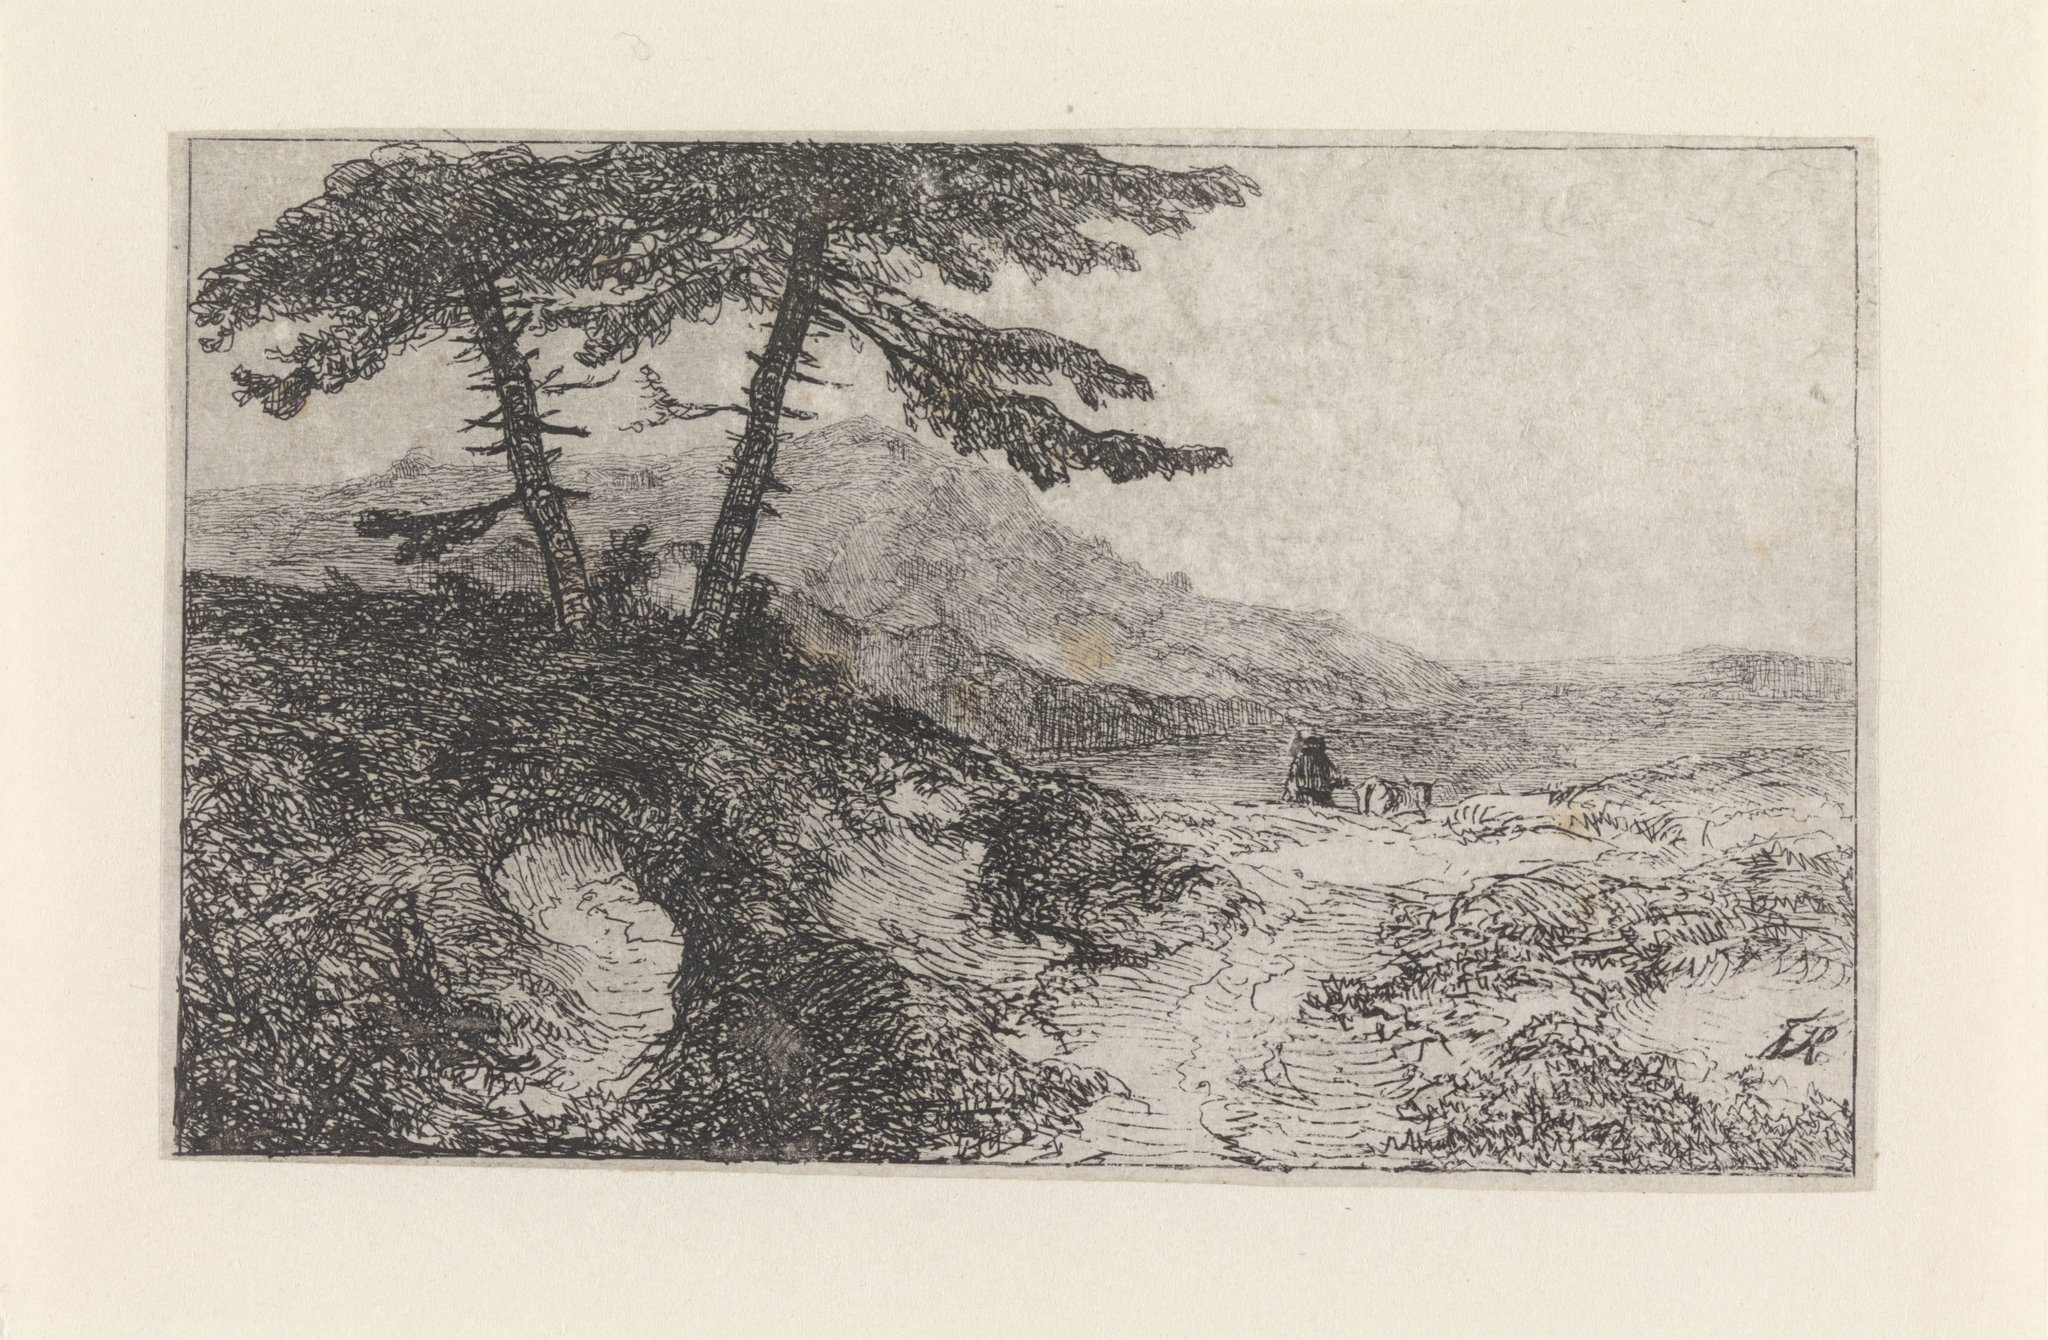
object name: print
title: Landschap met twee dennen op een heuvel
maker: johannes franciscus hoppenbrouwers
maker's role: draughtsman, painter, print maker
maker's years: 1819-1866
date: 1829-1866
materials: paper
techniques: etching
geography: the hague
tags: herding, herdsman, herdswoman, shepherd, shepherdess, cowherd, etc., dunes (sea not visible); in the dunes, groups of trees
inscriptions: collector's mark: Lugt 2760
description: Duinlandschap met links op de voorgrond twee dennen op een heuvel. In in het midden een figuur met een koe op een pad.